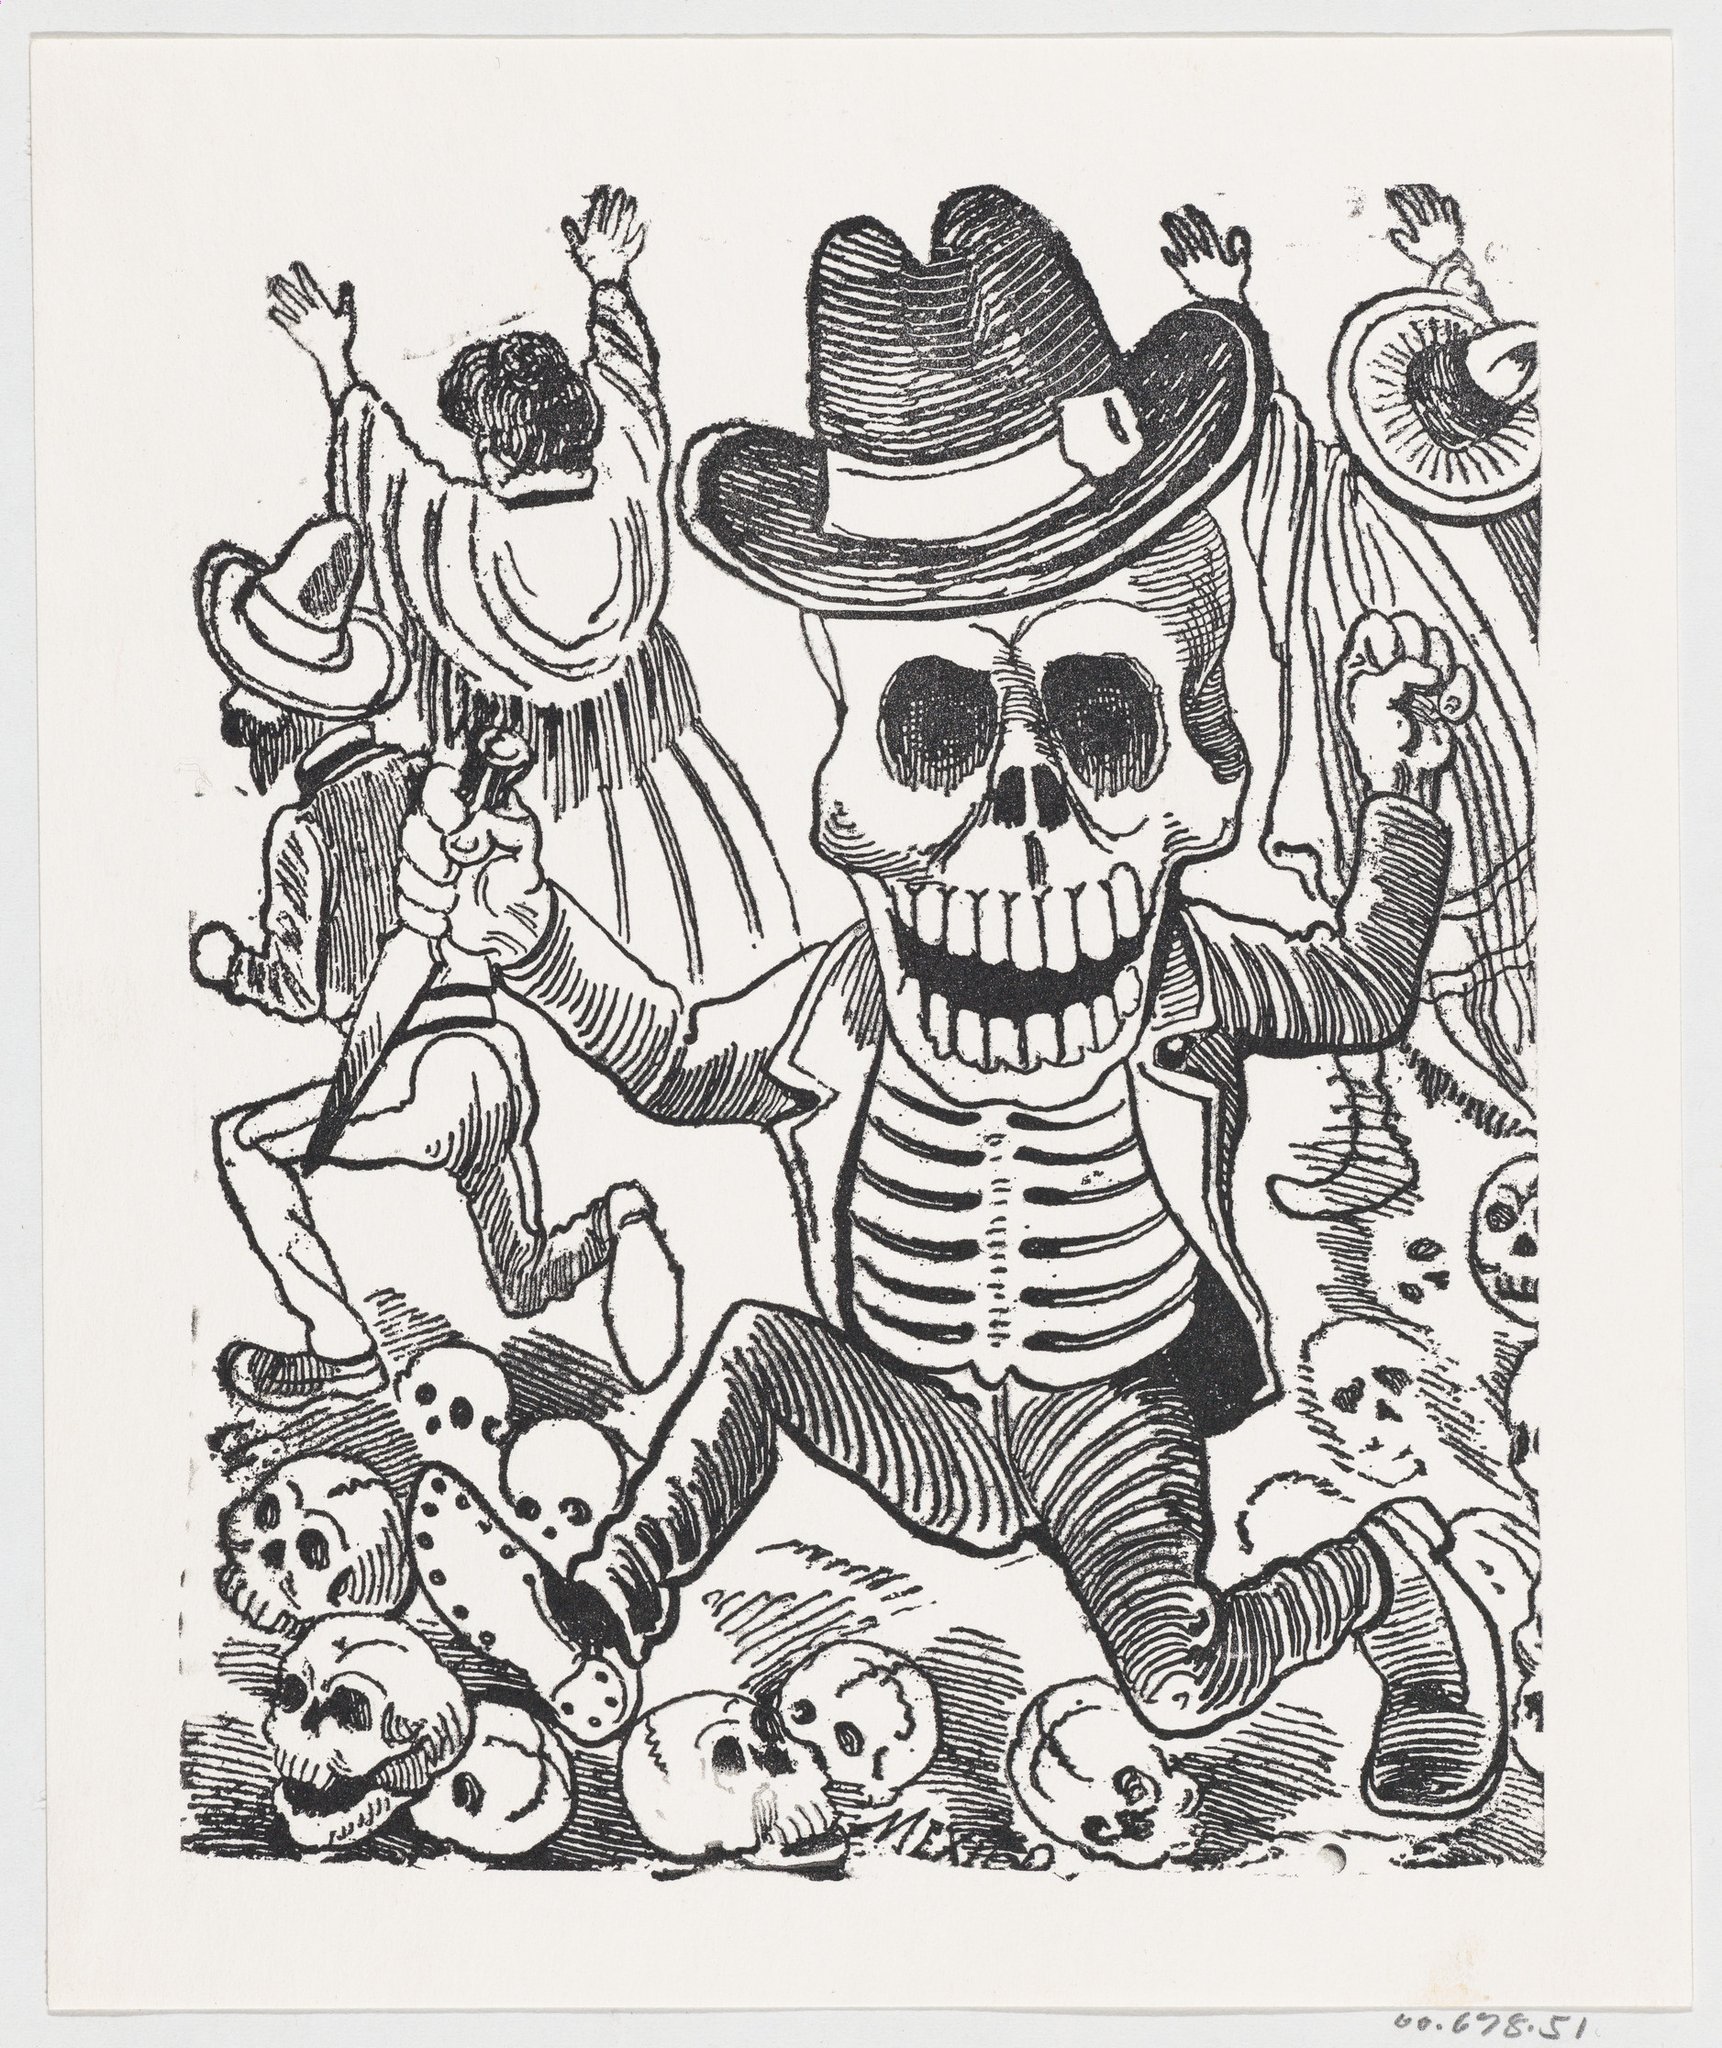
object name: print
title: A skeleton holding a knife leaping over a pile of skulls, people flee in the background, from a broadside entitled 'Las bravisimas calaveras Guatemaltecas'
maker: josé guadalupe posada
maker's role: artist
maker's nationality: mexican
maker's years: 1852-1913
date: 1907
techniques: lithography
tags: skeletons,skulls